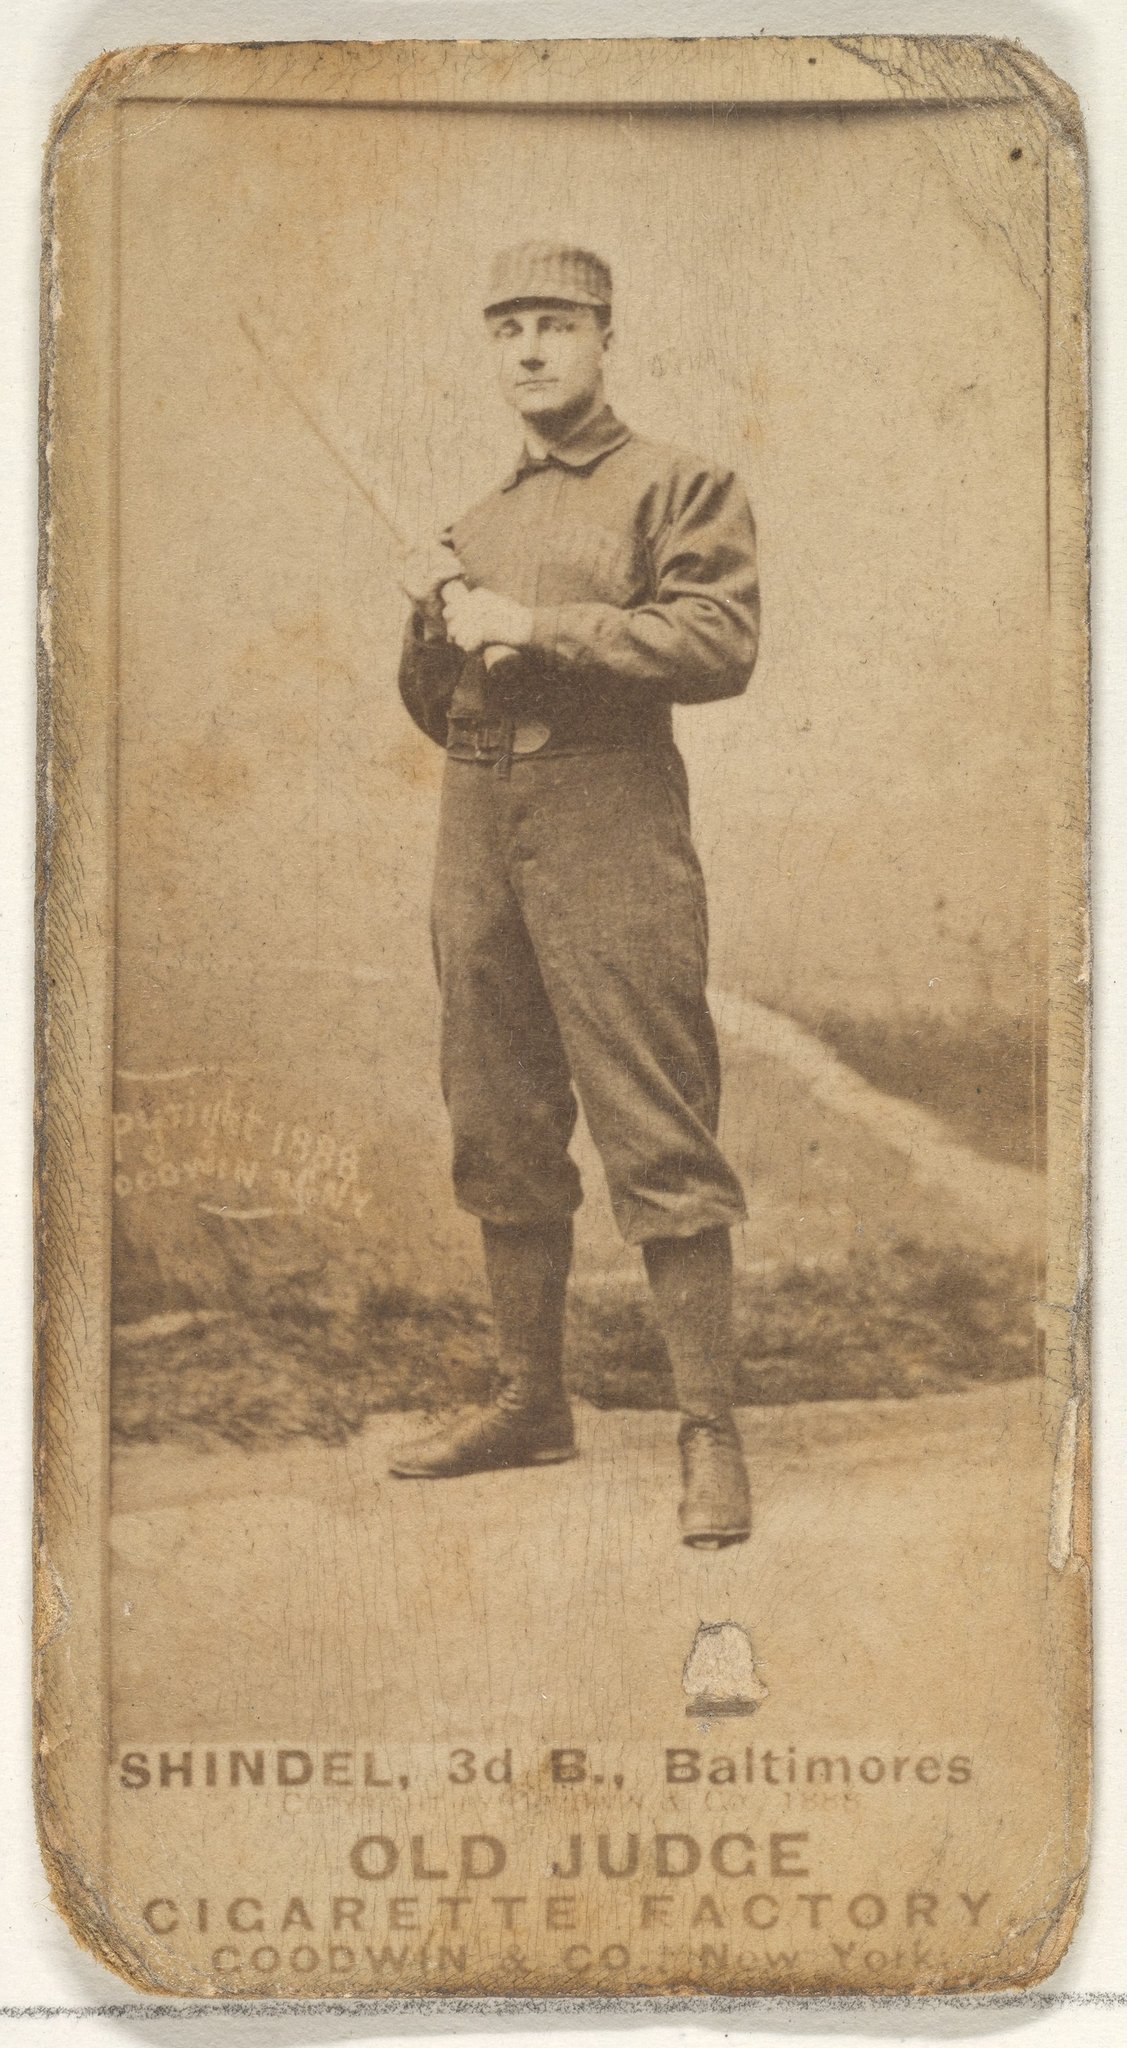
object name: baseball card, photograph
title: Shindle, 3rd Base, Baltimore Orioles, from the Old Judge series (N172) for Old Judge Cigarettes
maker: goodwin & company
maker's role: publisher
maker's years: 1850-1950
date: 1888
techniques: albumen silver print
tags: men,portraits,baseball,athletes